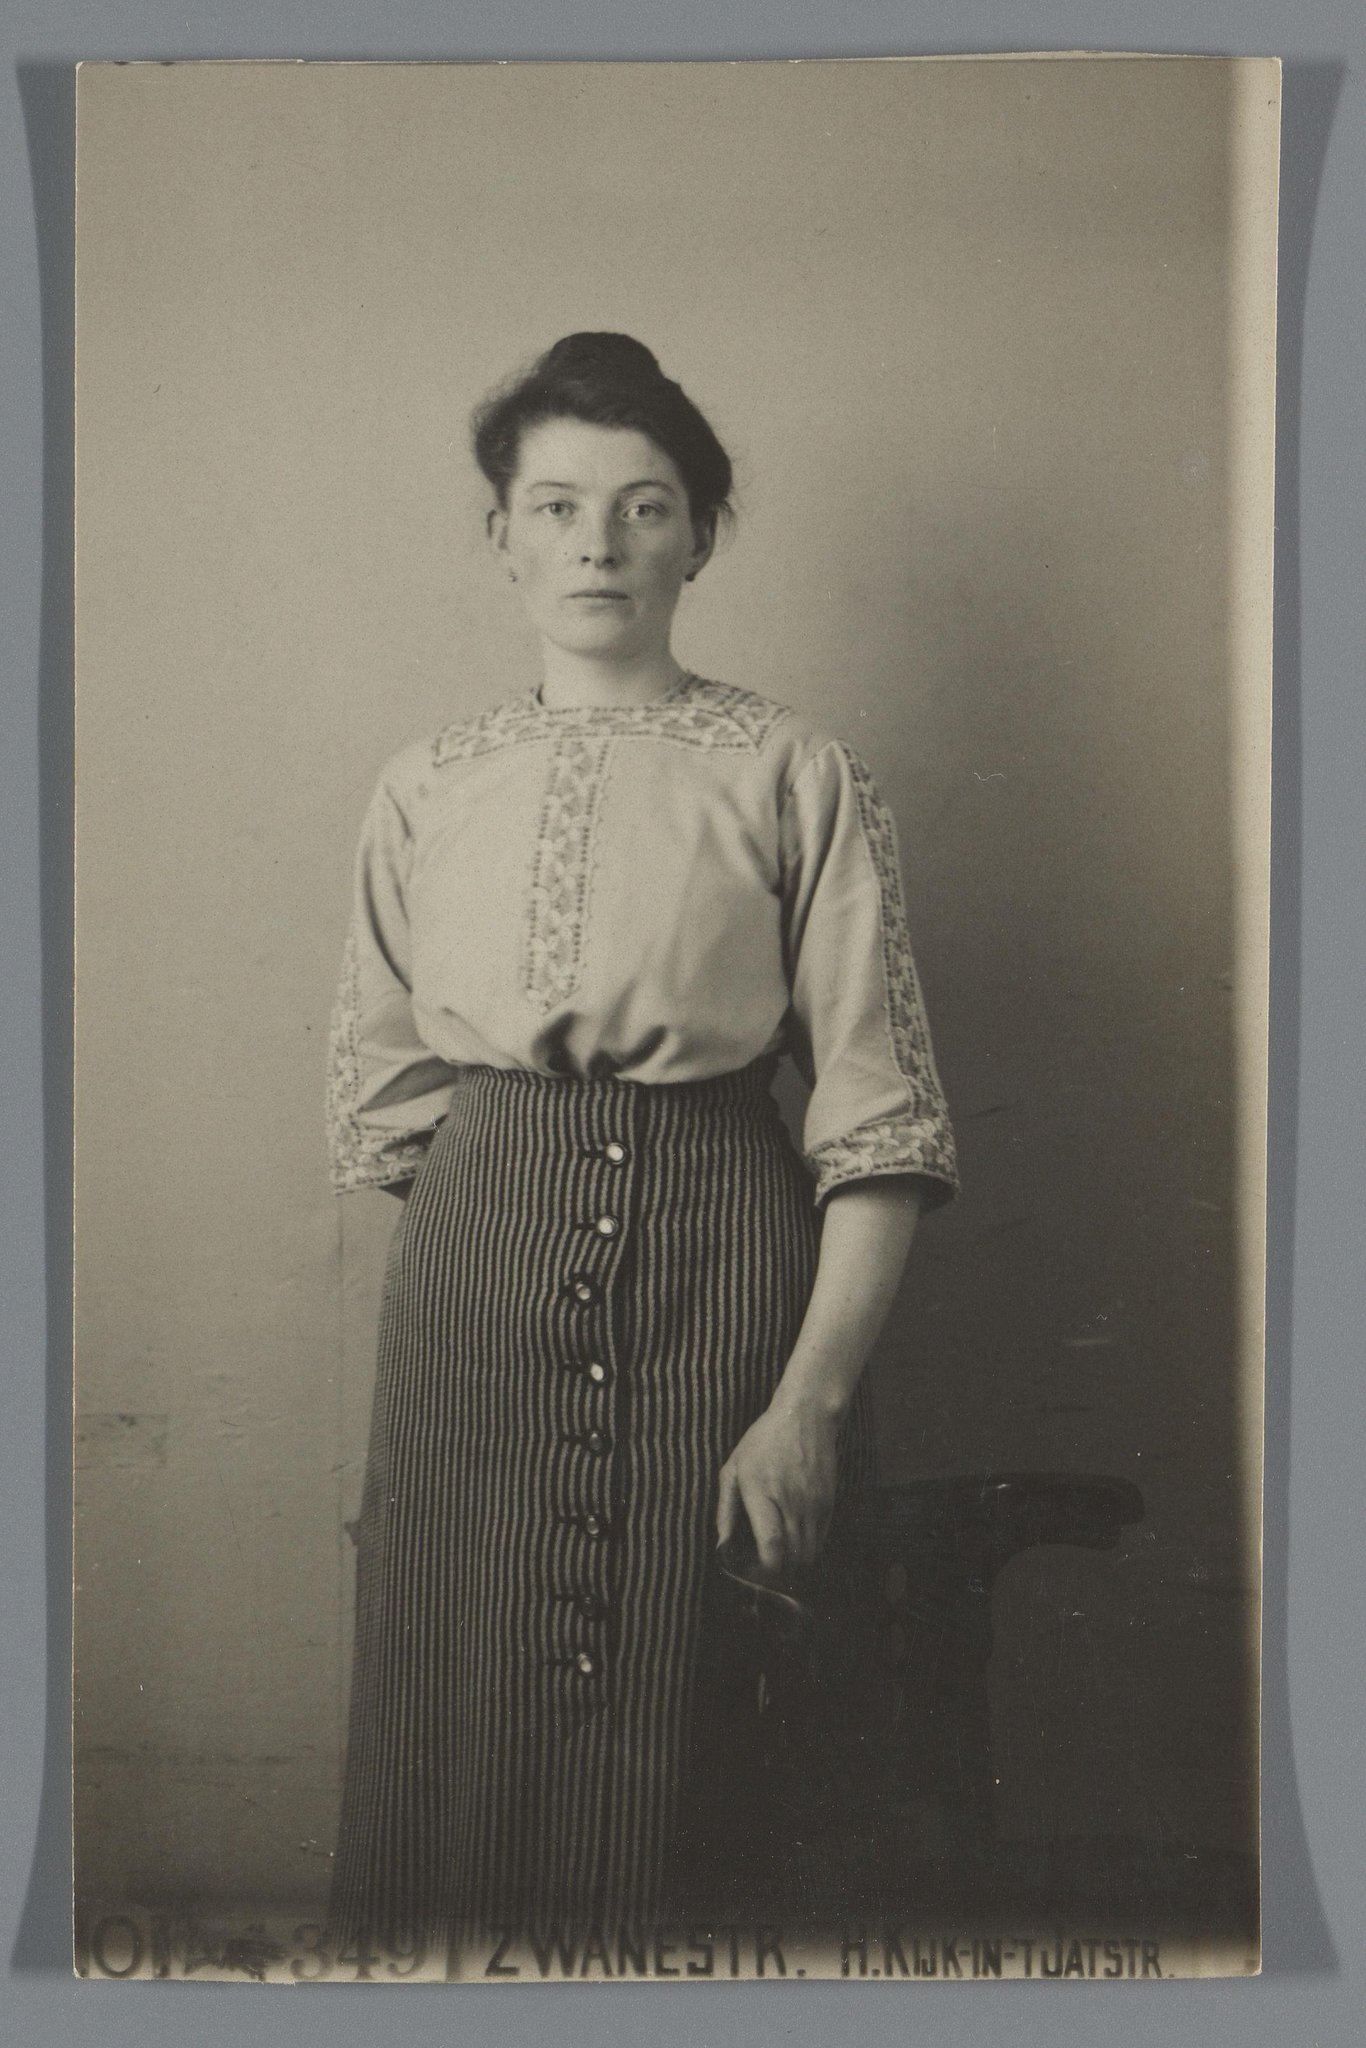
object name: snapshot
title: Portret van een vrouw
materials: photographic support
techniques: gelatin silver print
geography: groningen